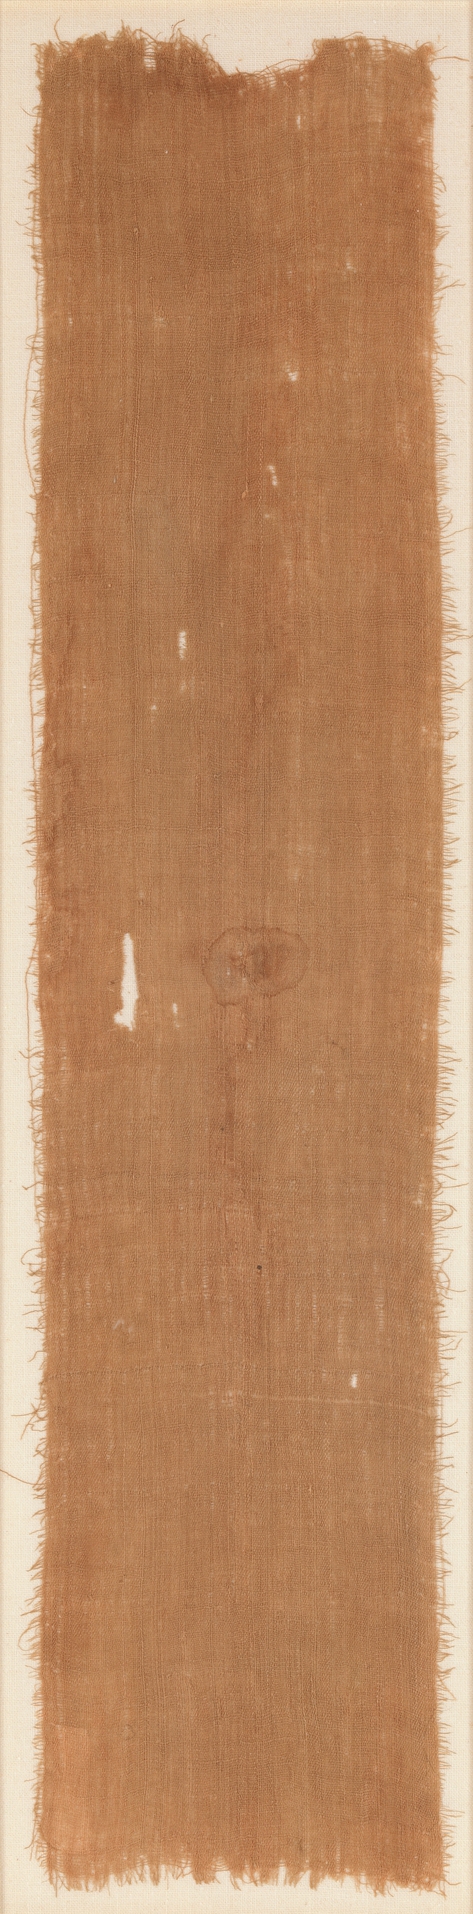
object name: cloth sample, djedptahefankh, pink dye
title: Mummy Cloth Fragment of Djedptahefankh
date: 1070-945 BCE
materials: linen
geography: egypt